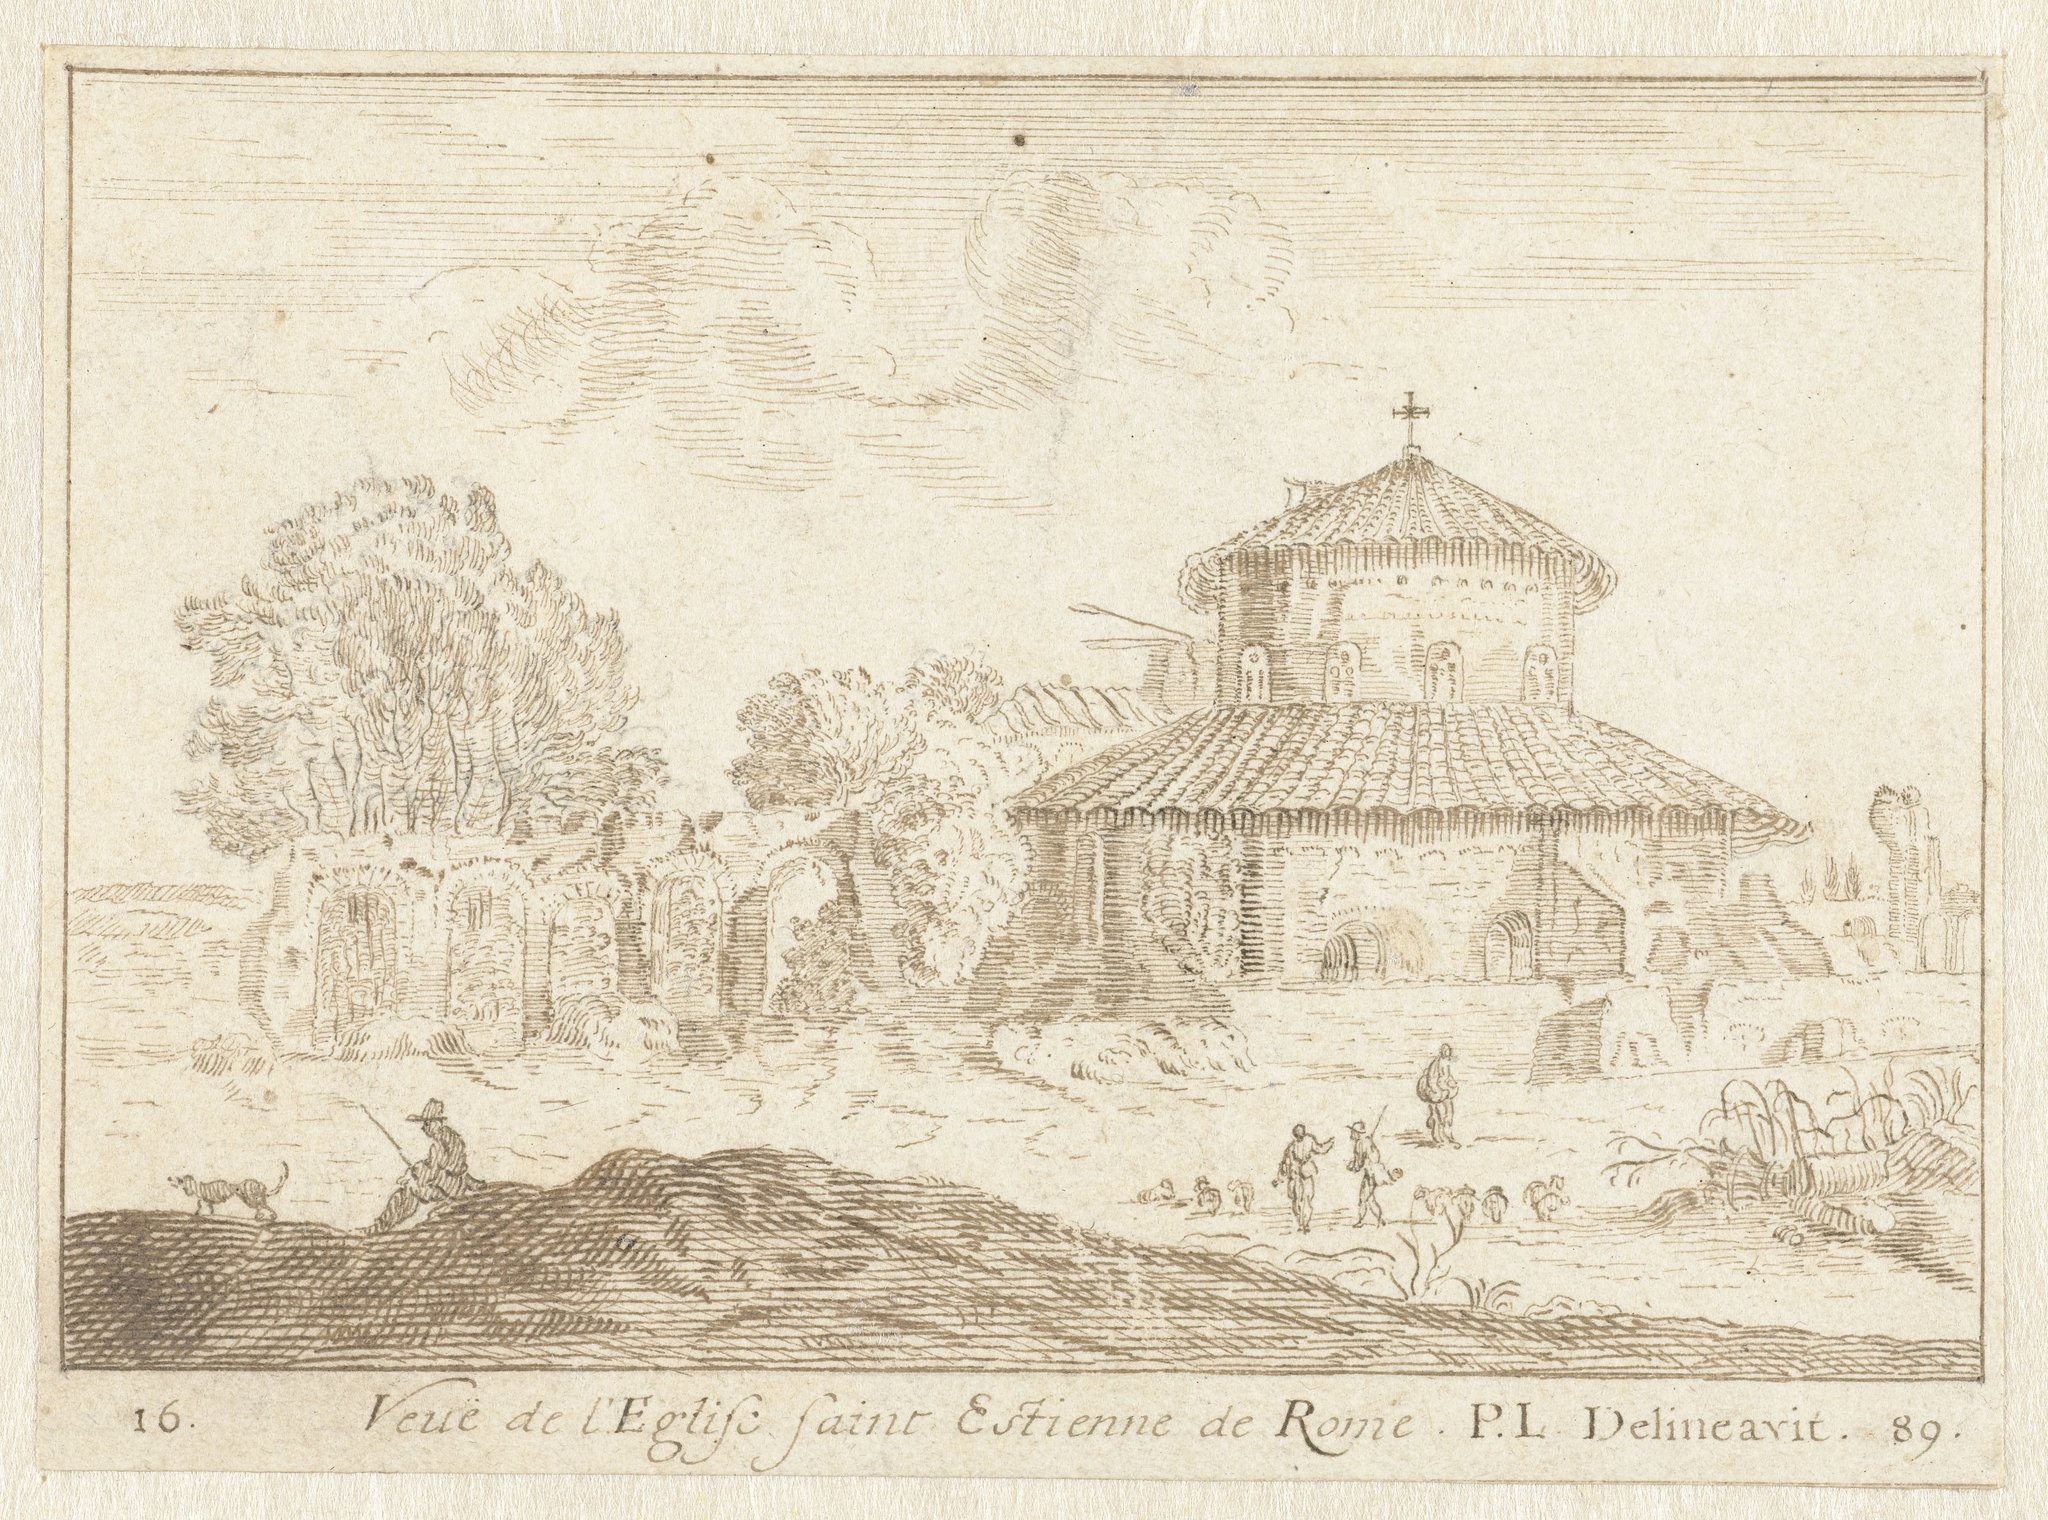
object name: drawing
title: Santo Stefano Rotondo te Rome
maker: monogrammist pl (tekenaar)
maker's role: draughtsman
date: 1689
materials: ink, paper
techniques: pen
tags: church (exterior), rome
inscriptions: : ‘Veue de l'Eglise saint Estienne de Rome’